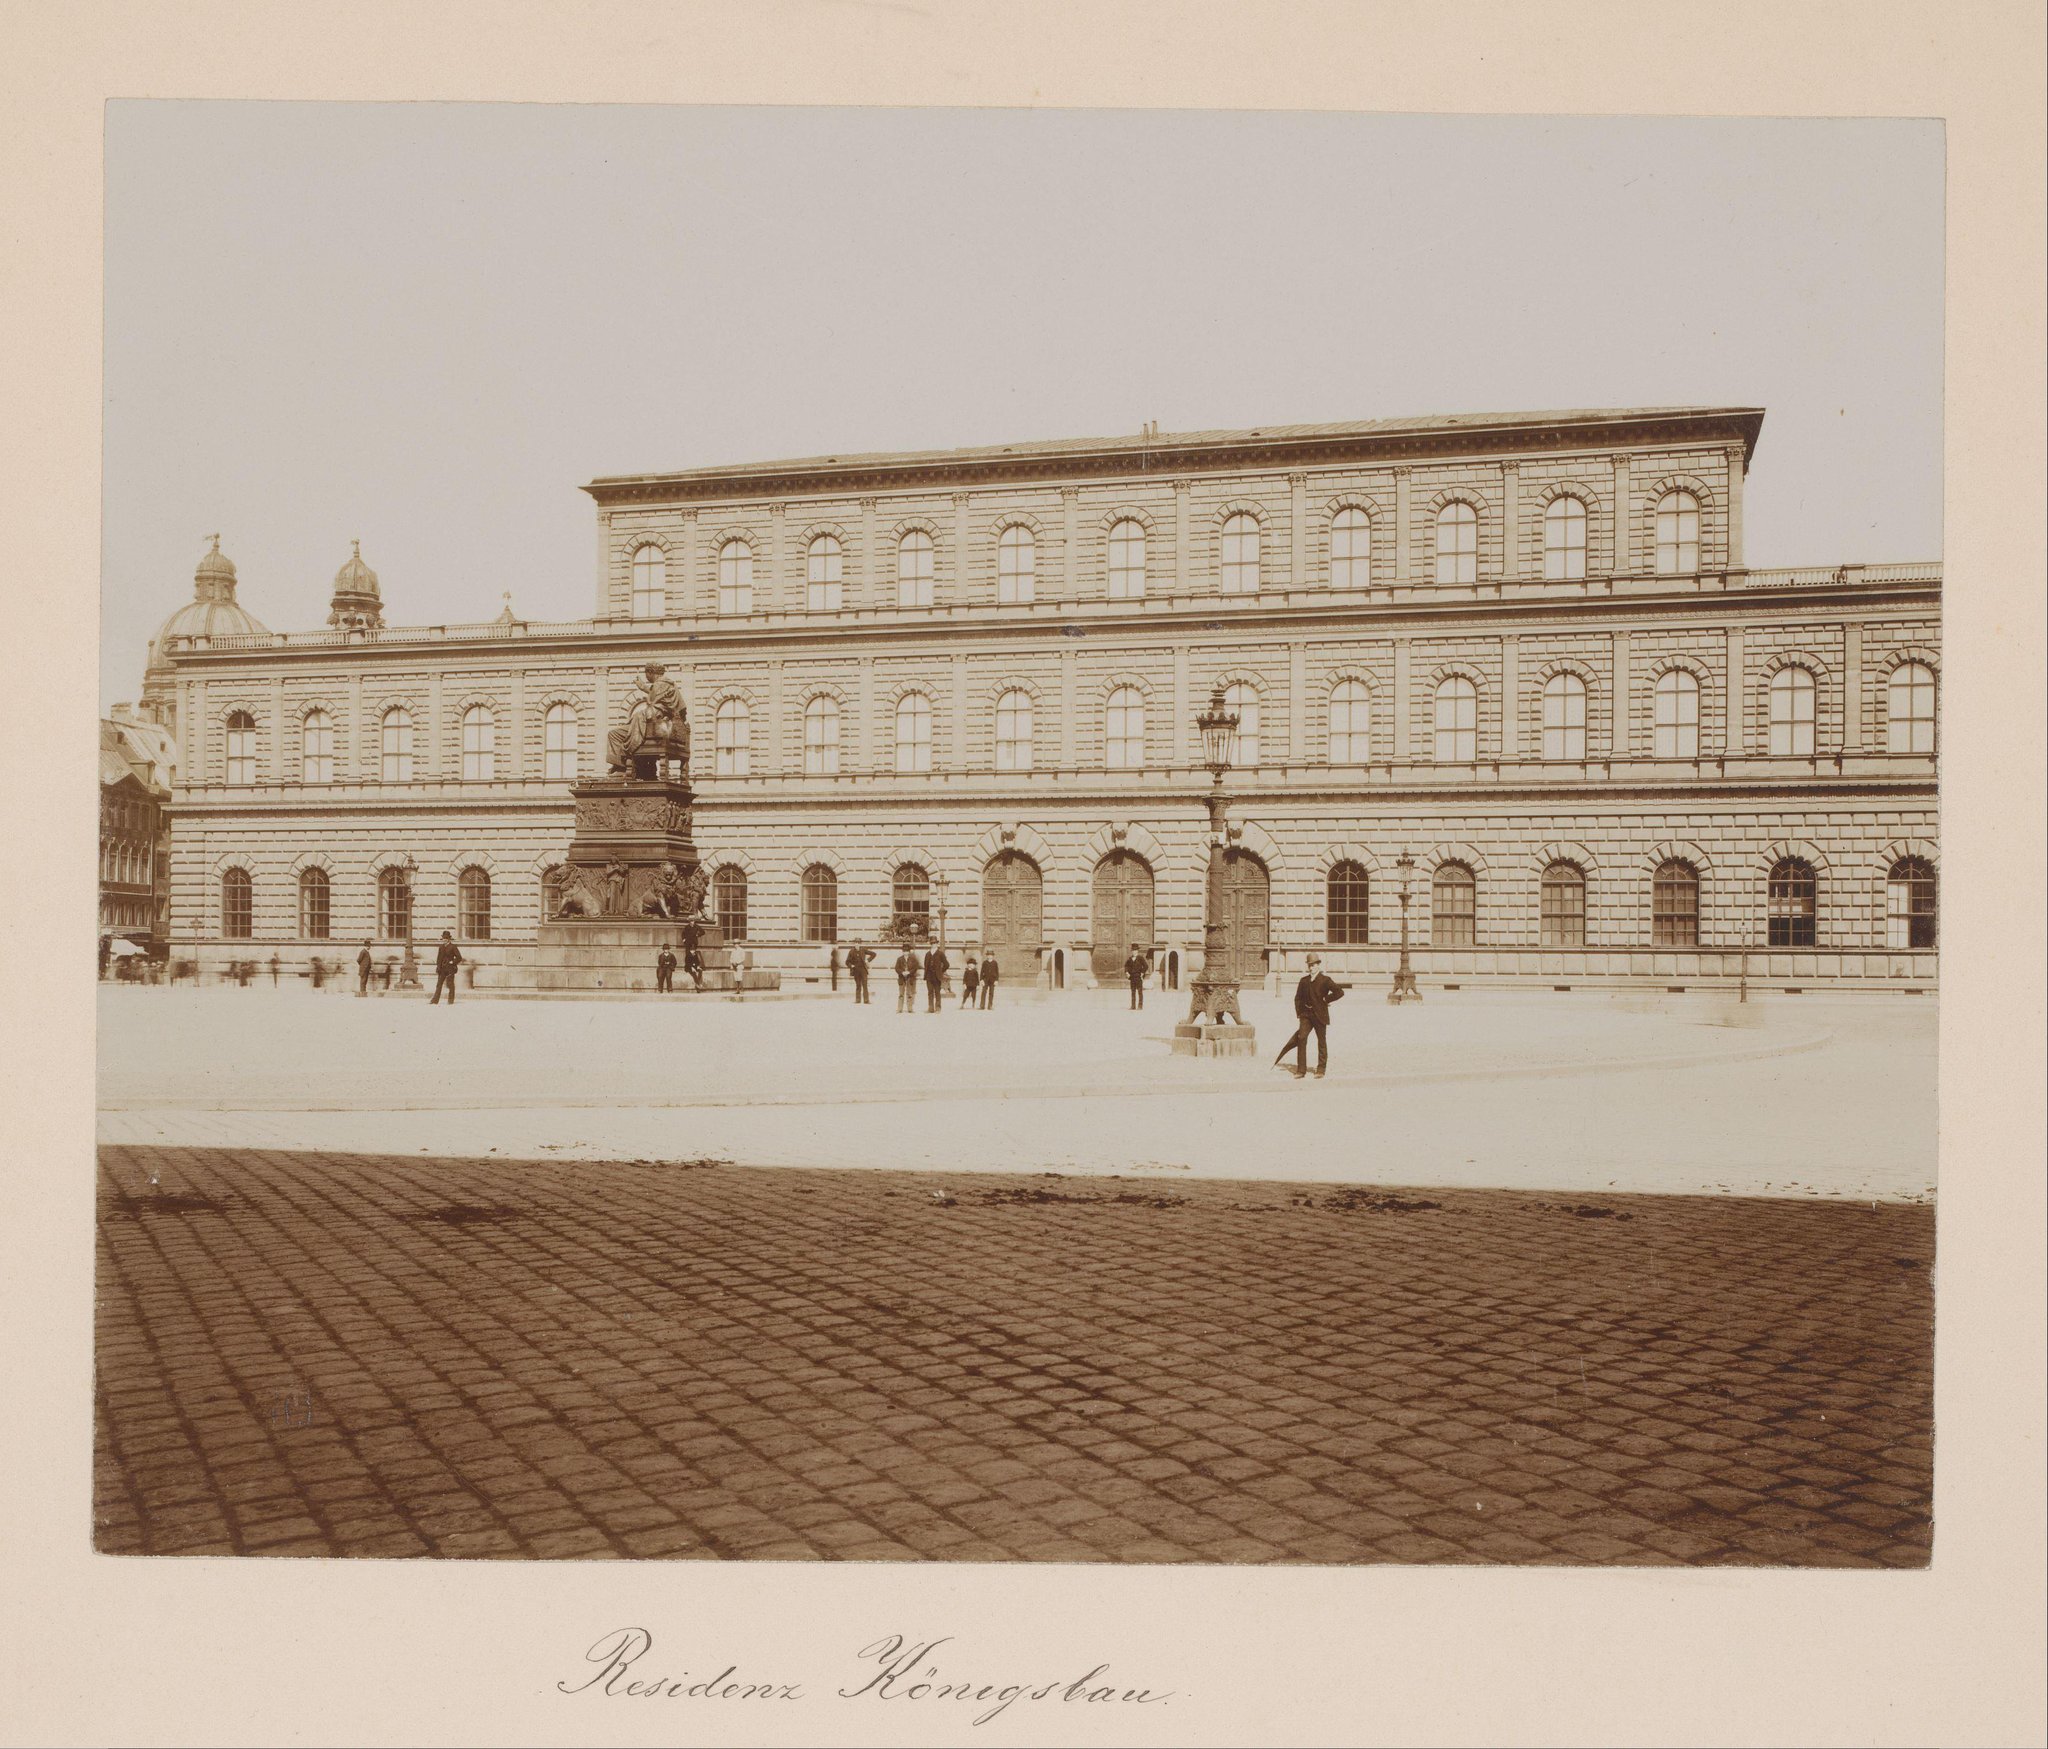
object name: photograph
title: Residenz Königsbau, München, Duitsland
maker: Anonymous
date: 1880-1910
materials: cardboard, photographic support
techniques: collodion silver print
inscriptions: inscription: ‘Residenz Königsbau’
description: Gezicht op de Residenz Königsbau, München, Duitsland. Enkele mensen in elegante kleding poseren hier en daar.